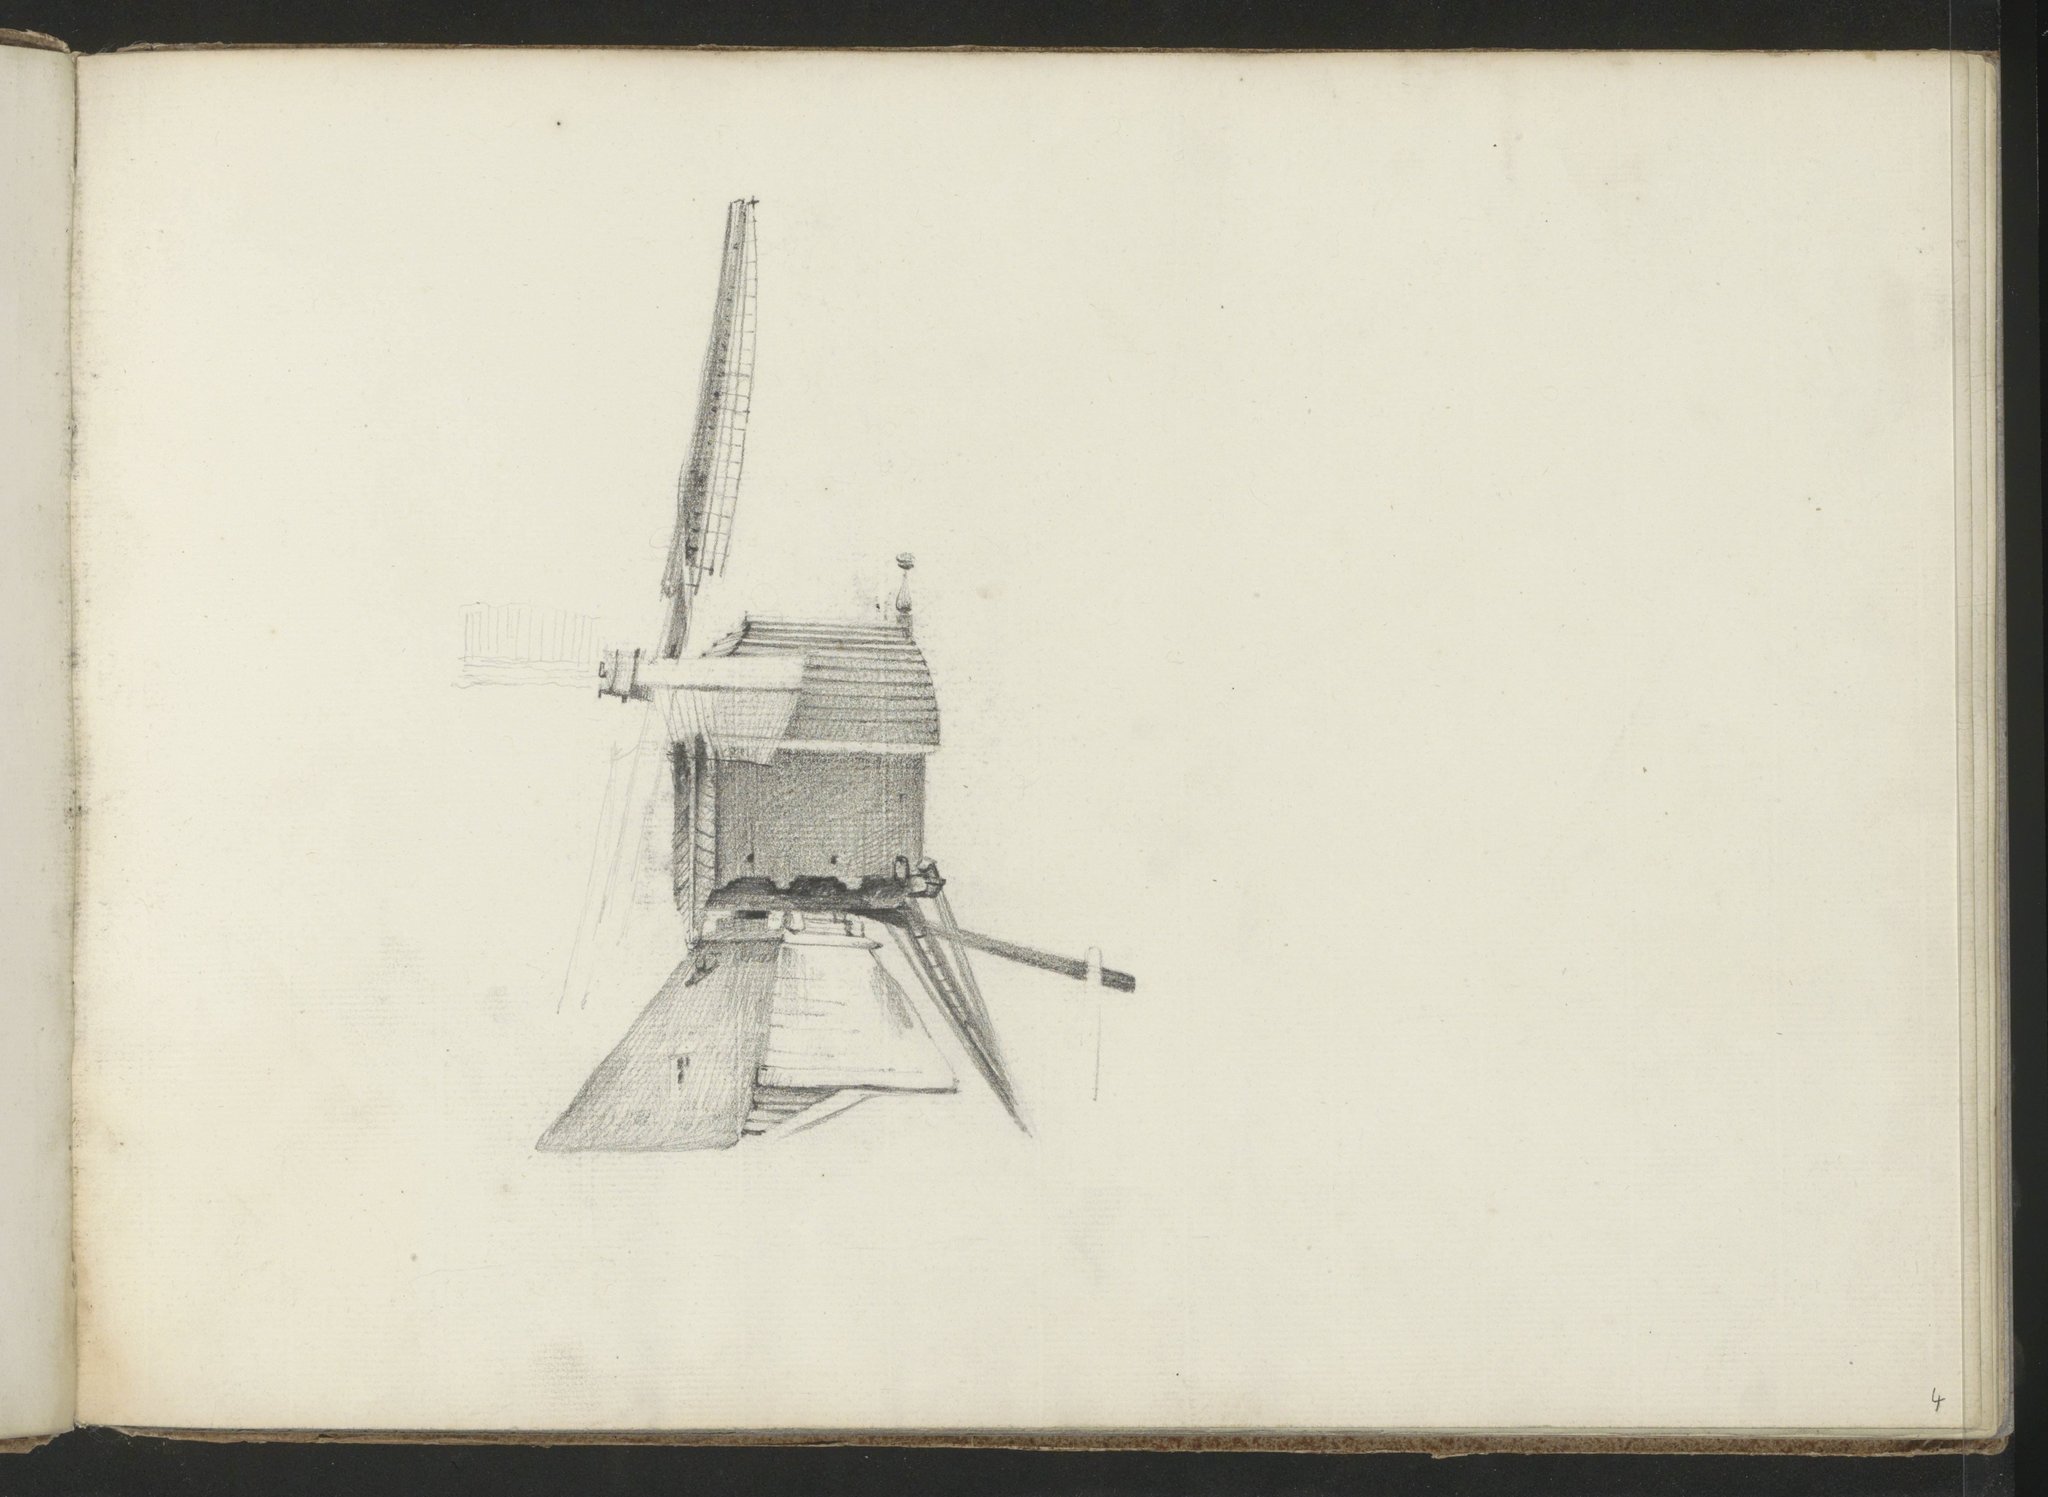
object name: sketchbook leaf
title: Windmolen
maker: s. altmann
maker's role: painter, print maker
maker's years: 1822-1890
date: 1803-1840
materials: paper, pencil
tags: windmill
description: Blad 4 recto uit een schetsboek met 24 bladen.